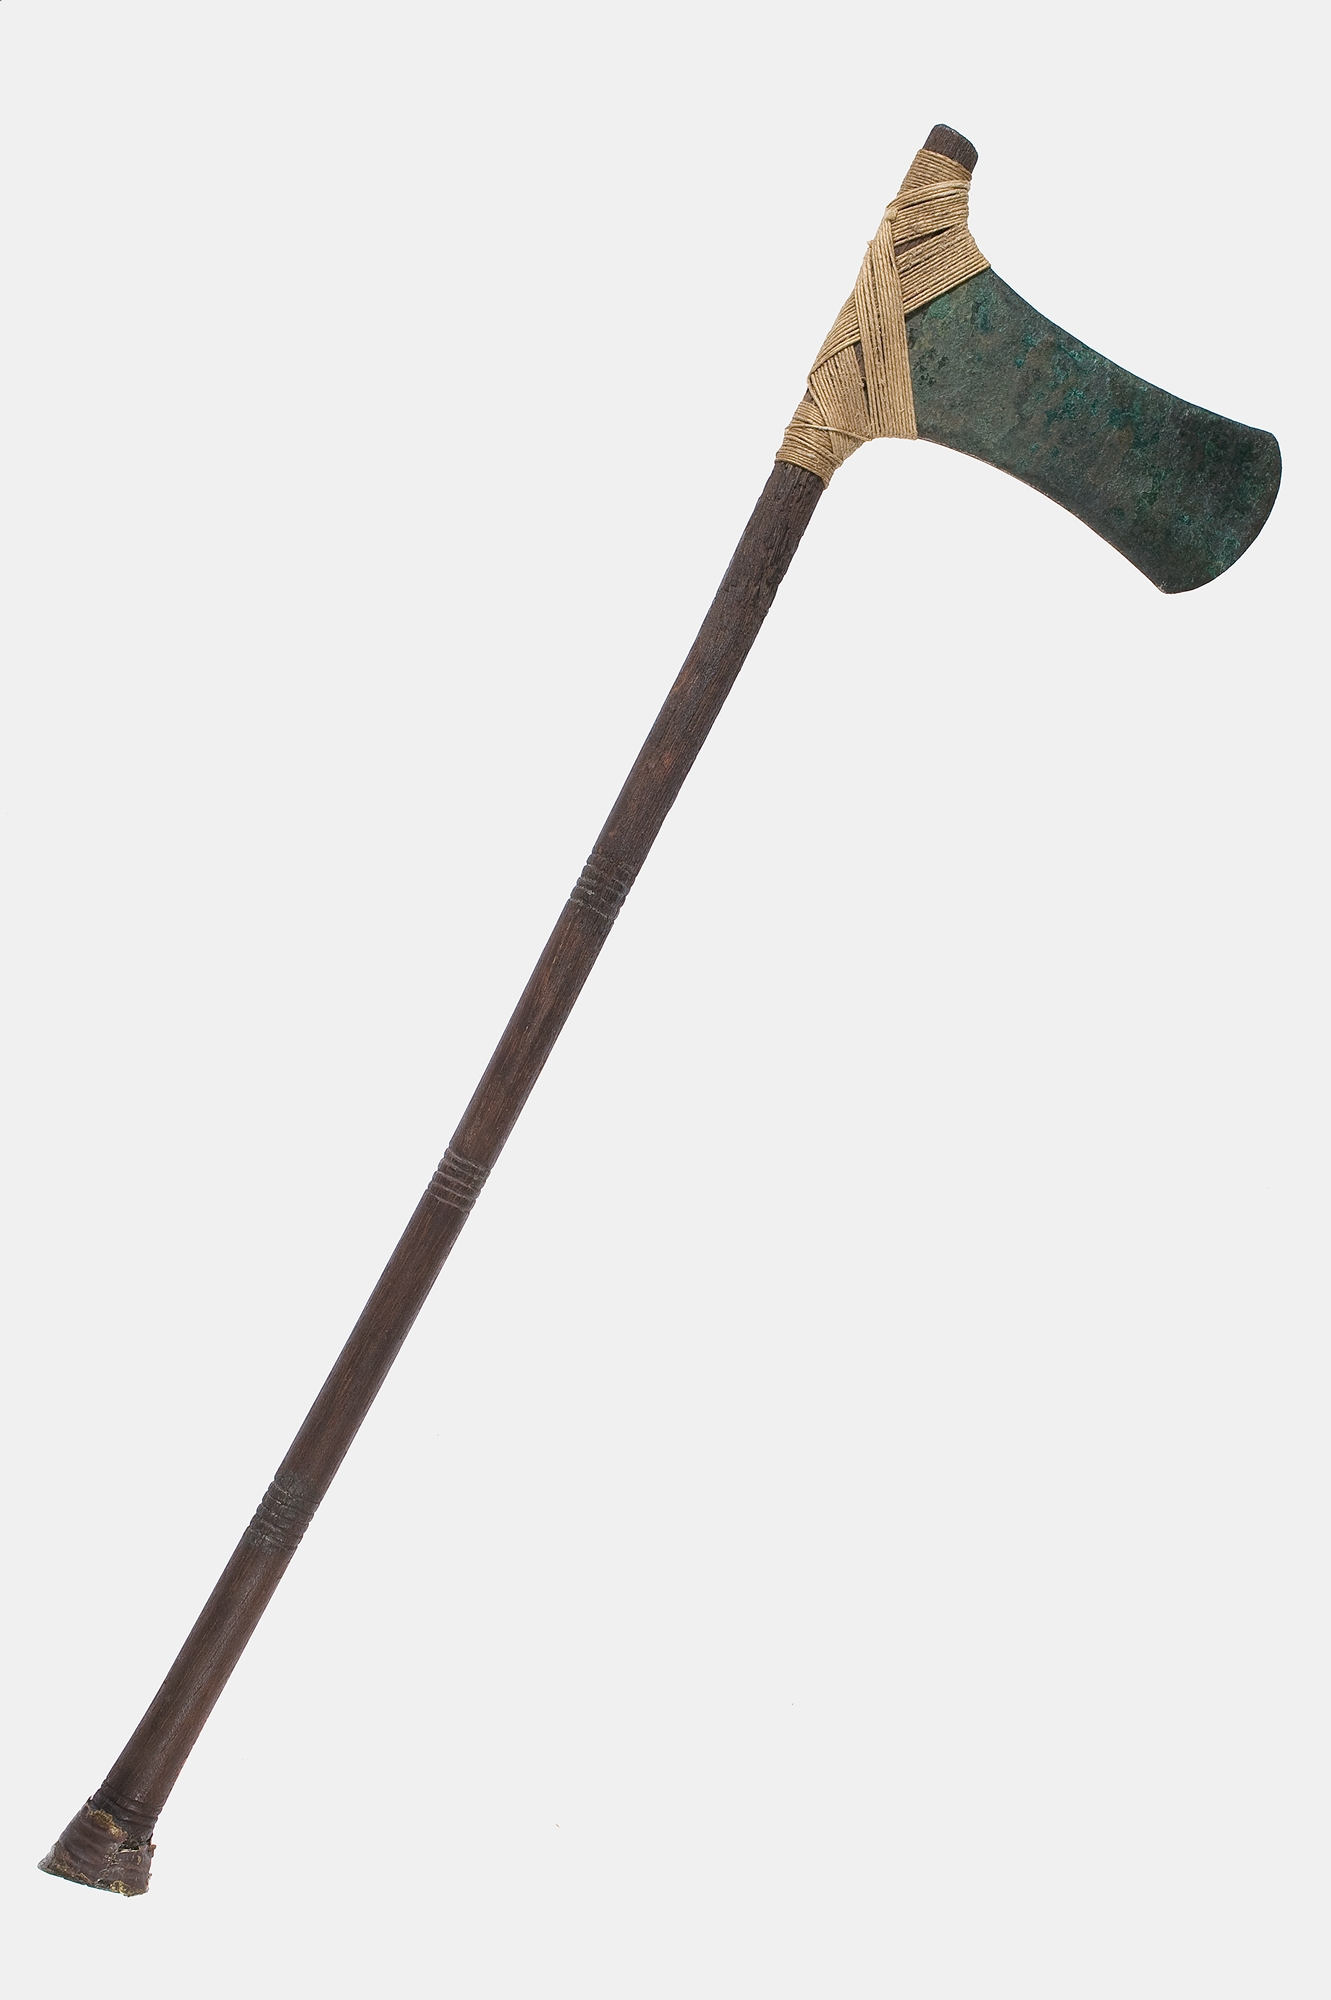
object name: model ax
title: Ax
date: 1550-1295 BCE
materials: bronze, copper alloy, gold leaf, wood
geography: egypt